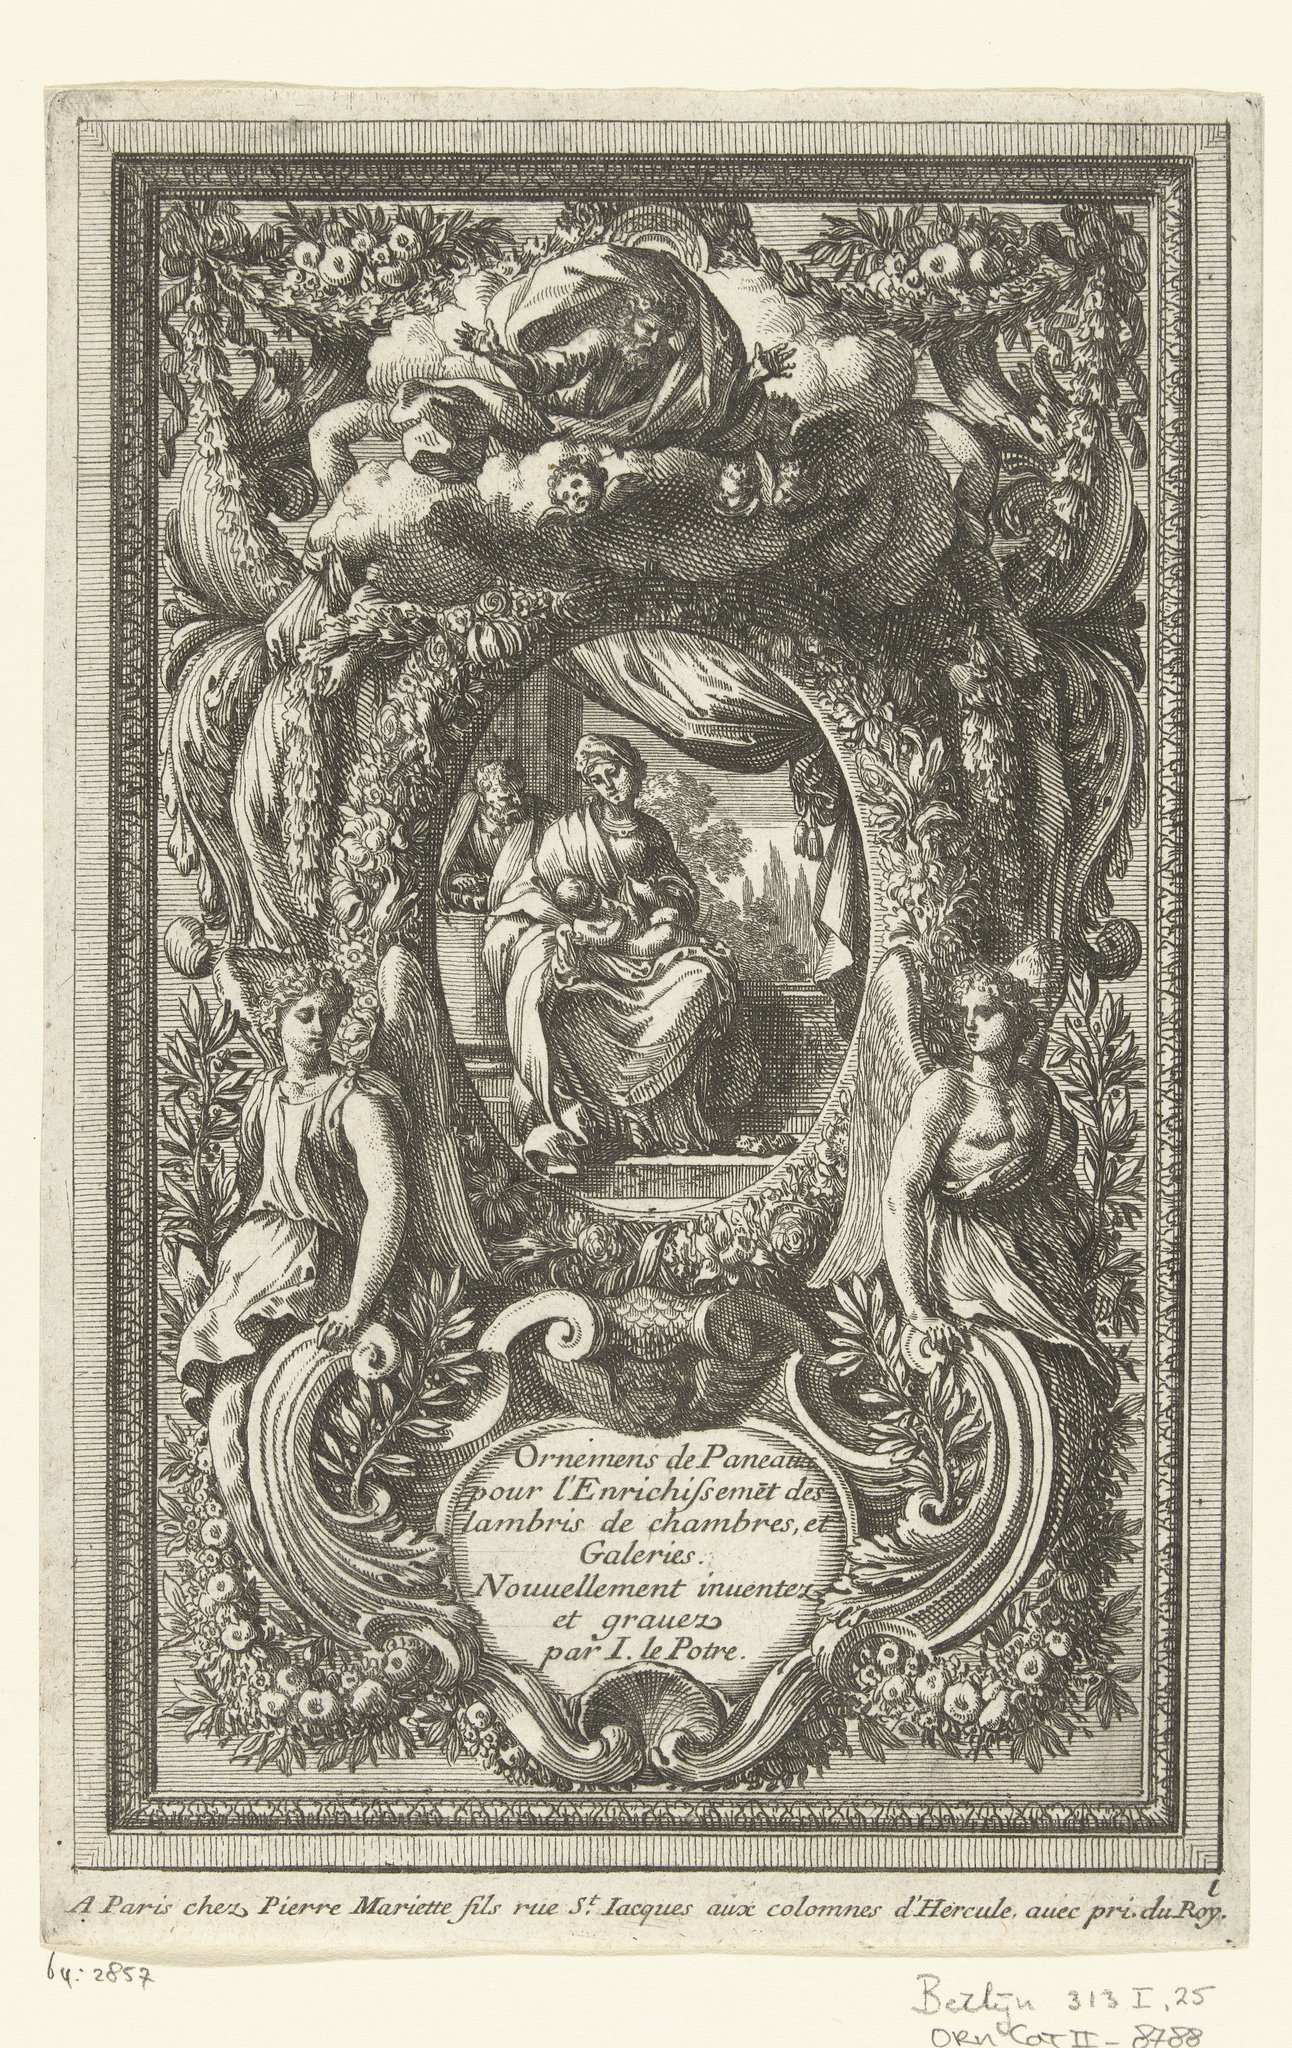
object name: ornament print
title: Ornemens de Paneaux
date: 1655-1657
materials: paper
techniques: etching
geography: paris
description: Paneel in architectonisch lijstwerk met een ovaal medaillon met de Heilige Maagd, Jozef en Christus in het midden; bovenaan God de Vader en onderaan een cartouche met de titel.